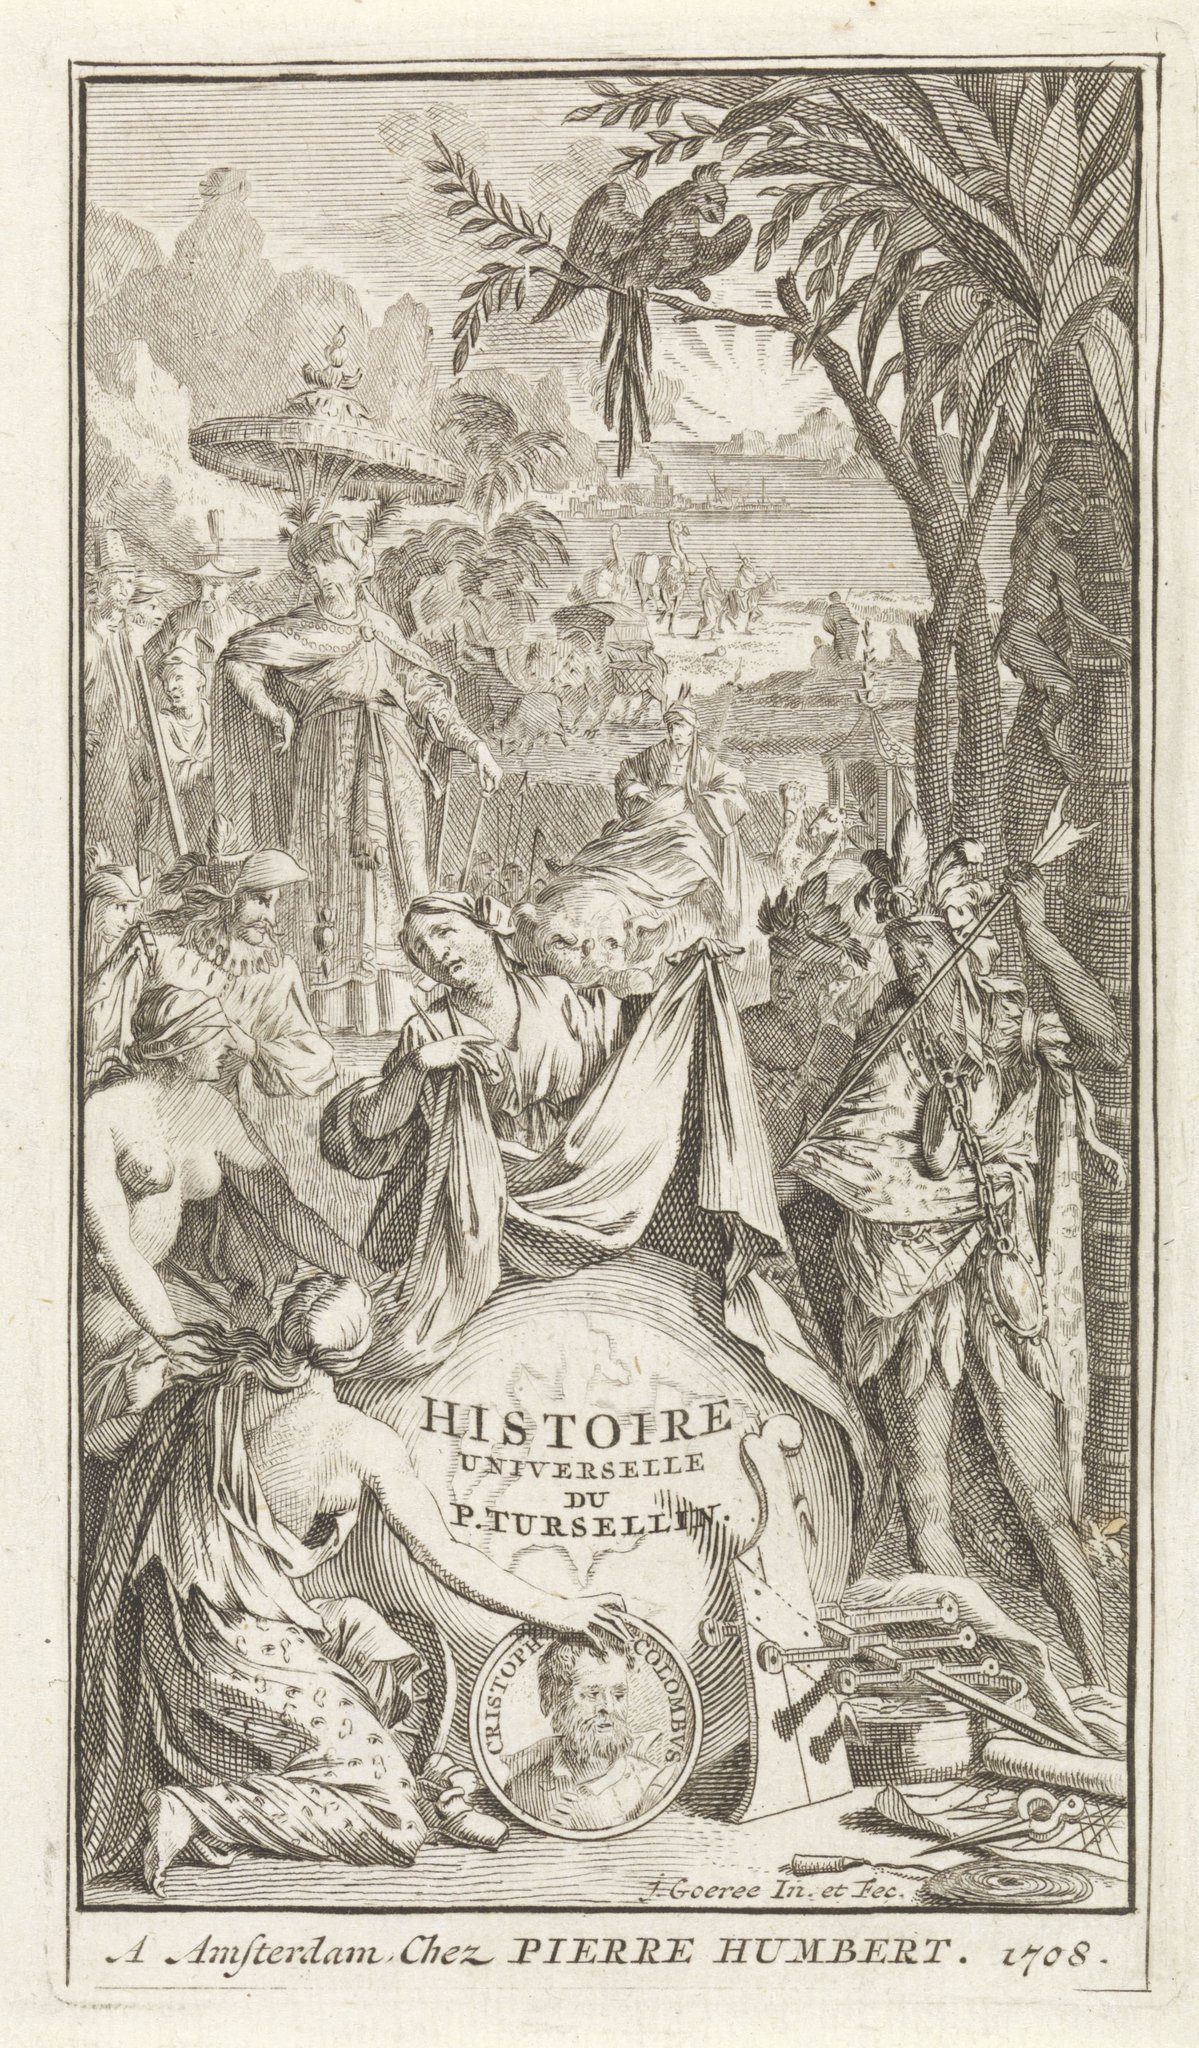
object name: titelblad, titelpagina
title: Titelpagina voor Orazio Torsellino, Histoire universelle, 1708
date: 1708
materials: paper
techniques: engraving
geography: amsterdam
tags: asiatic races and peoples: turks, africans, 'historia'; 'historia' (ripa), native peoples of the americas, fame; 'fama', 'fama buona', 'fama chiara' (ripa), globe, asiatic races and peoples: persians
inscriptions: date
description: In het midden een wereldbol met de titel van het boekwerk. De personificatie Geschiedenis staat achter de wereldbol en onthult deze. Op de voorgrond houdt Faam, gekleed in een gewaad bedrukt met ogen, het portret van Christoffel Columbus vast. Op de achtergrond de volkeren uit de hele wereld.